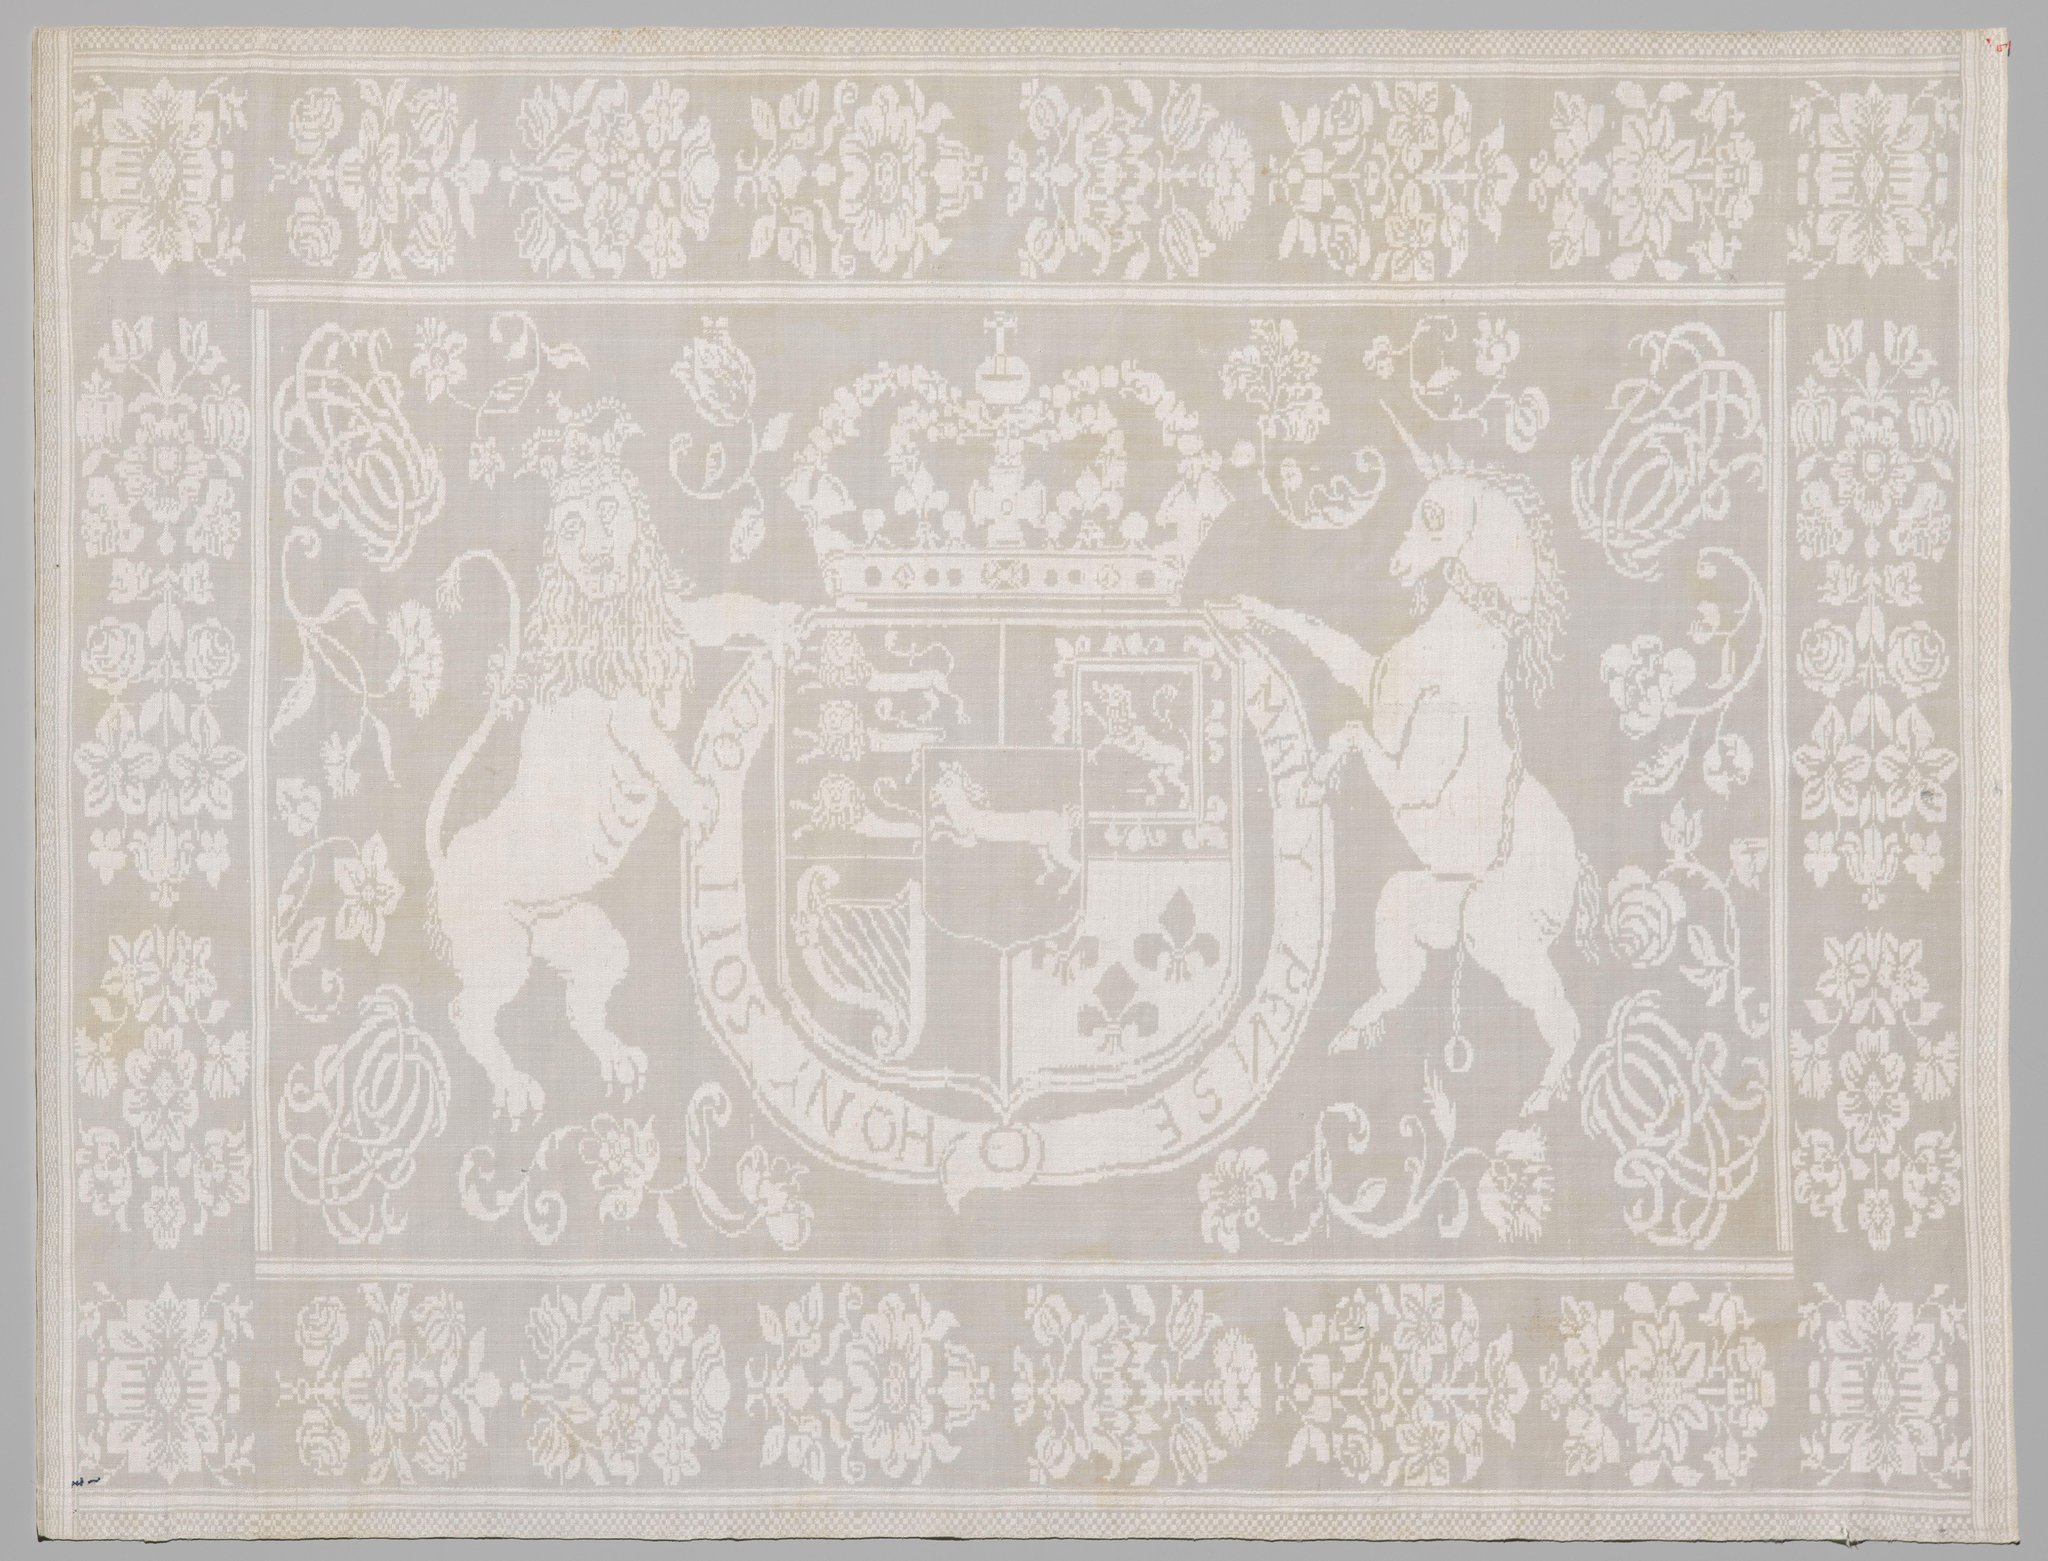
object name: napkin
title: Servet van wit linnendamast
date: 1700-1725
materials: linen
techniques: damask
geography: flanders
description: Servet van linnendamast met een leeuwen en een eenhoorn om een wapen met de letters HONY SOIT QUI MAL Y PENSE. Omlijst met bloemen. Langs de rand dambordpatroon.